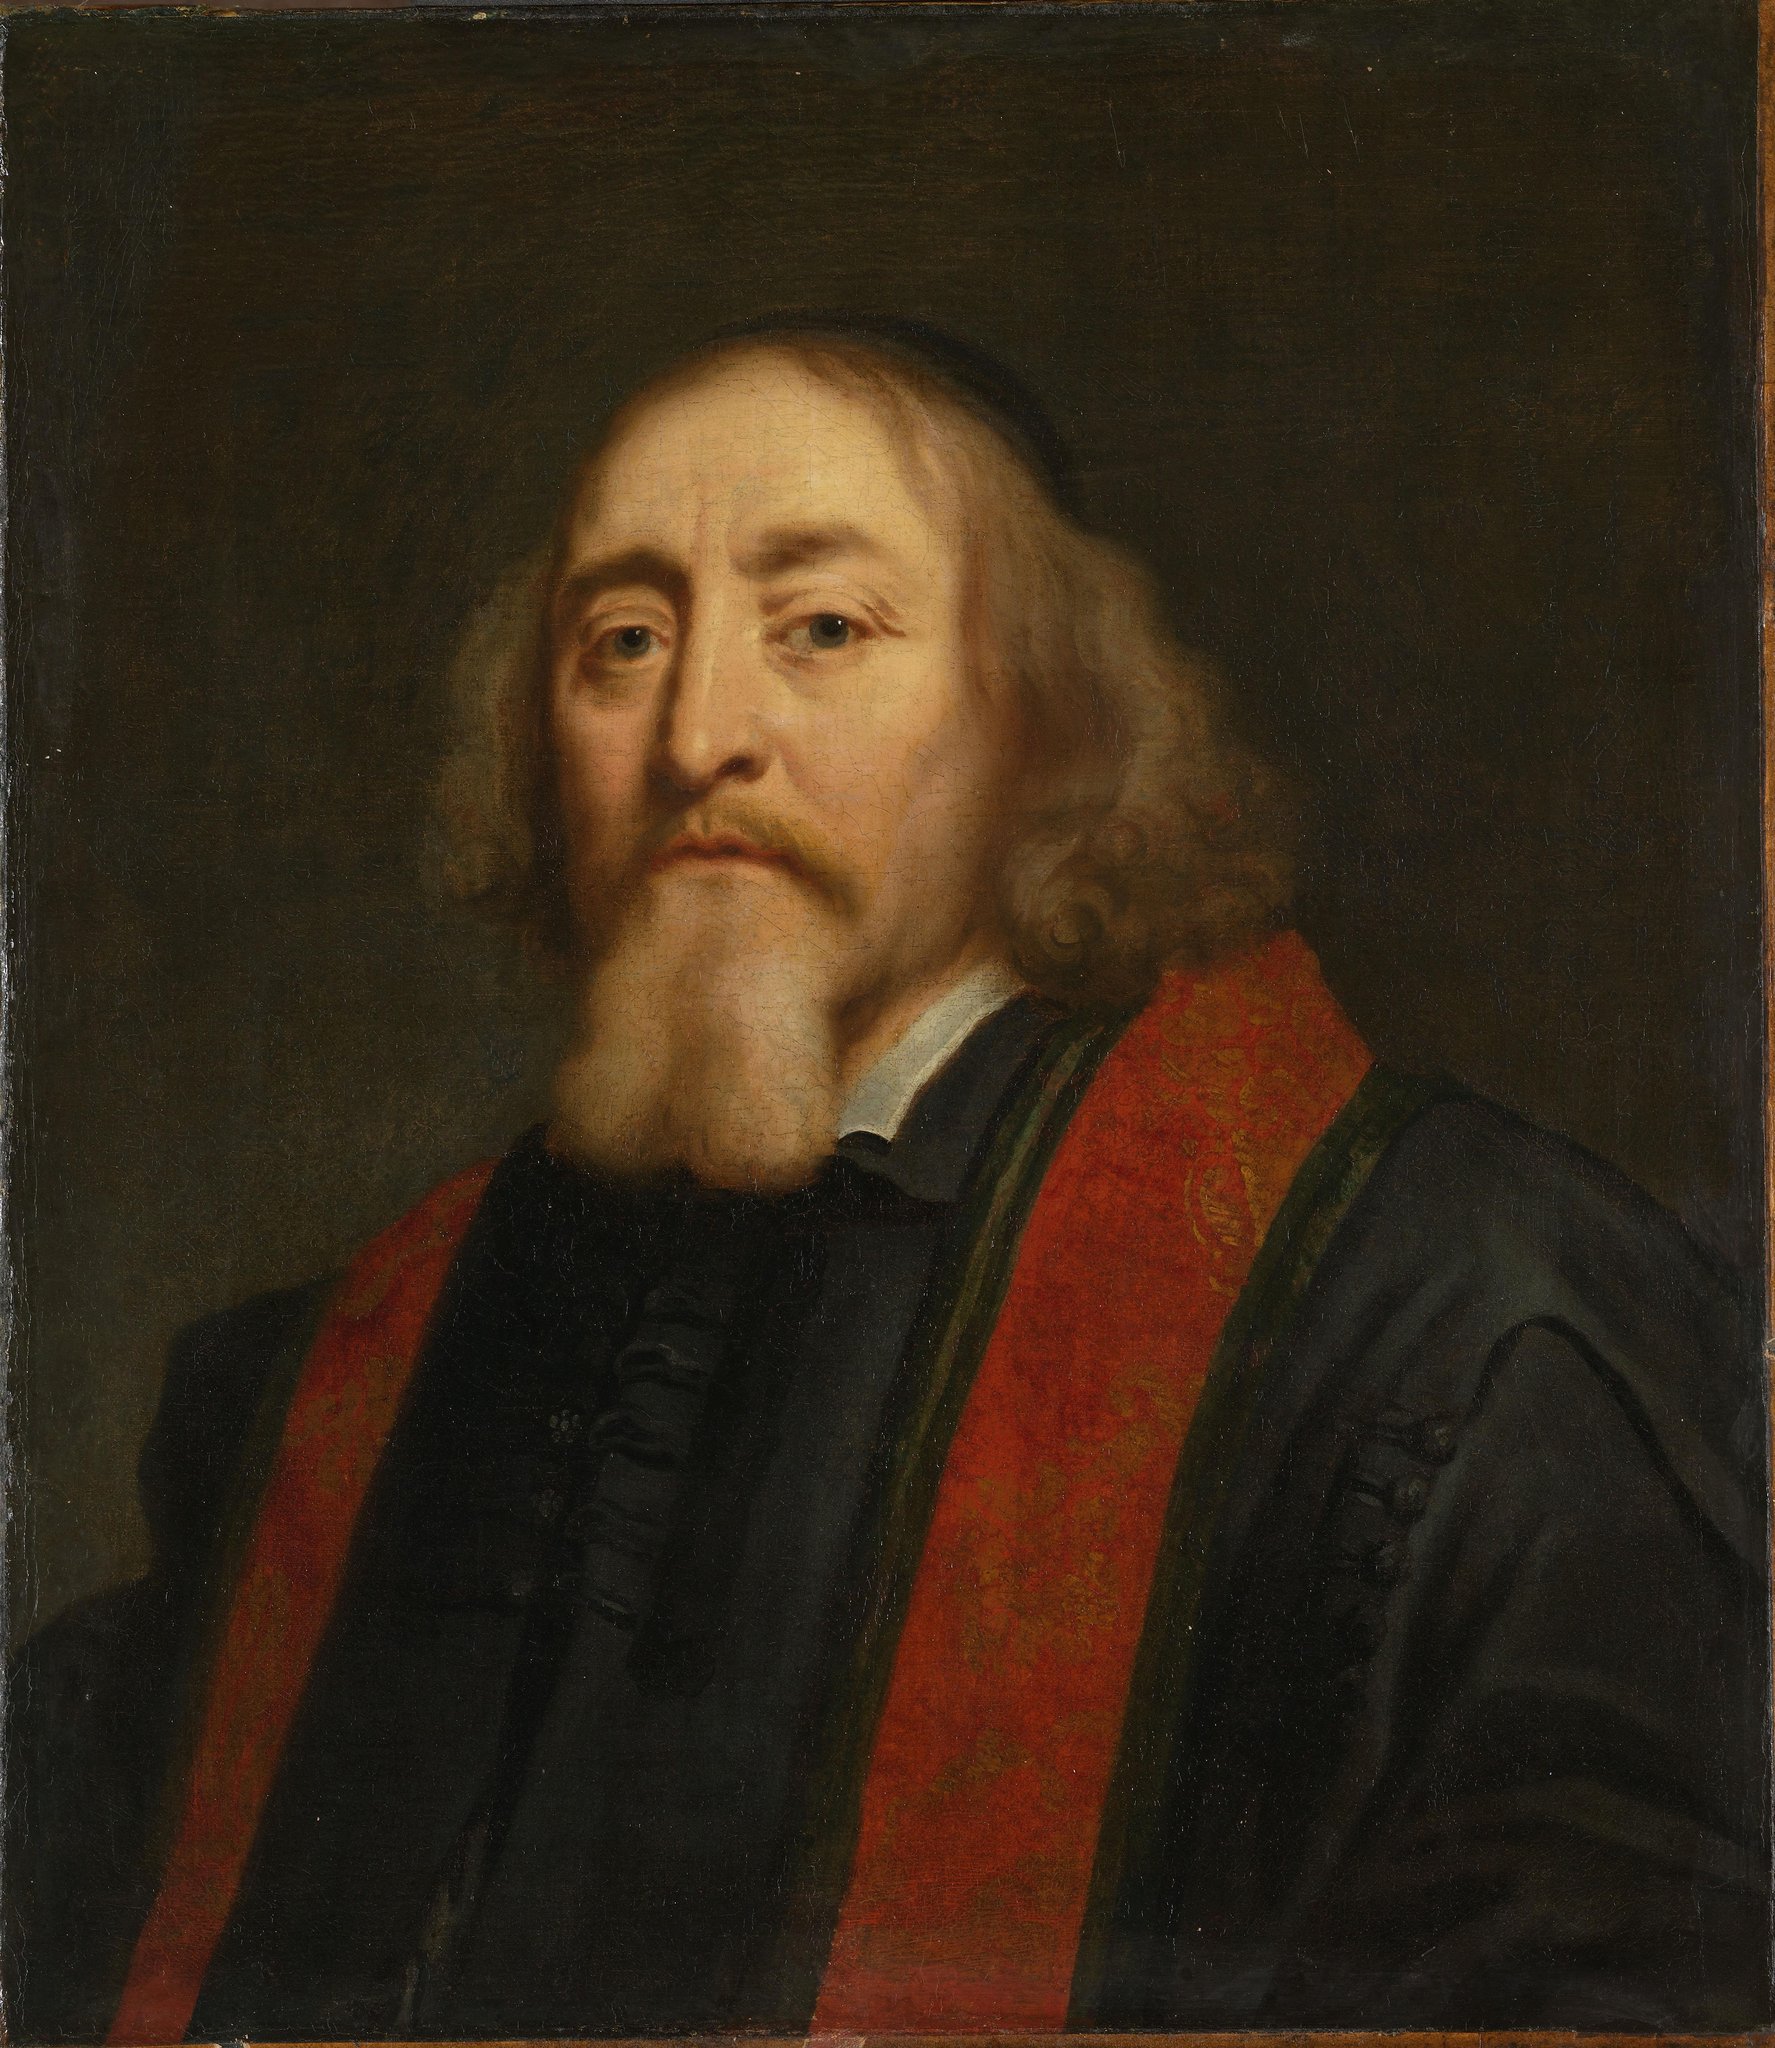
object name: painting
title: Jan Amos Comenius (Komensky) (1592-1670). Czech humanist and pedagogue. Exiled as a leader of the Moravian or Bohemian Brethren and settled in Amsterdam in 1656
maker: jürgen ovens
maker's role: draughtsman, painter, print maker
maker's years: 1623-1678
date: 1650-1670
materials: canvas, oil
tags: amsterdam, historical persons, functionaries and dignitaries ~ protestant churches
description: Portret van Jan Amos Comenius (Komensky) (1592-1670). Tsjechisch humanist en pedagoog. Als voorganger van de Moravische of Boheemse Broedergemeente verdreven en sedert 1656 gevestigd te Amsterdam. Buste naar links.